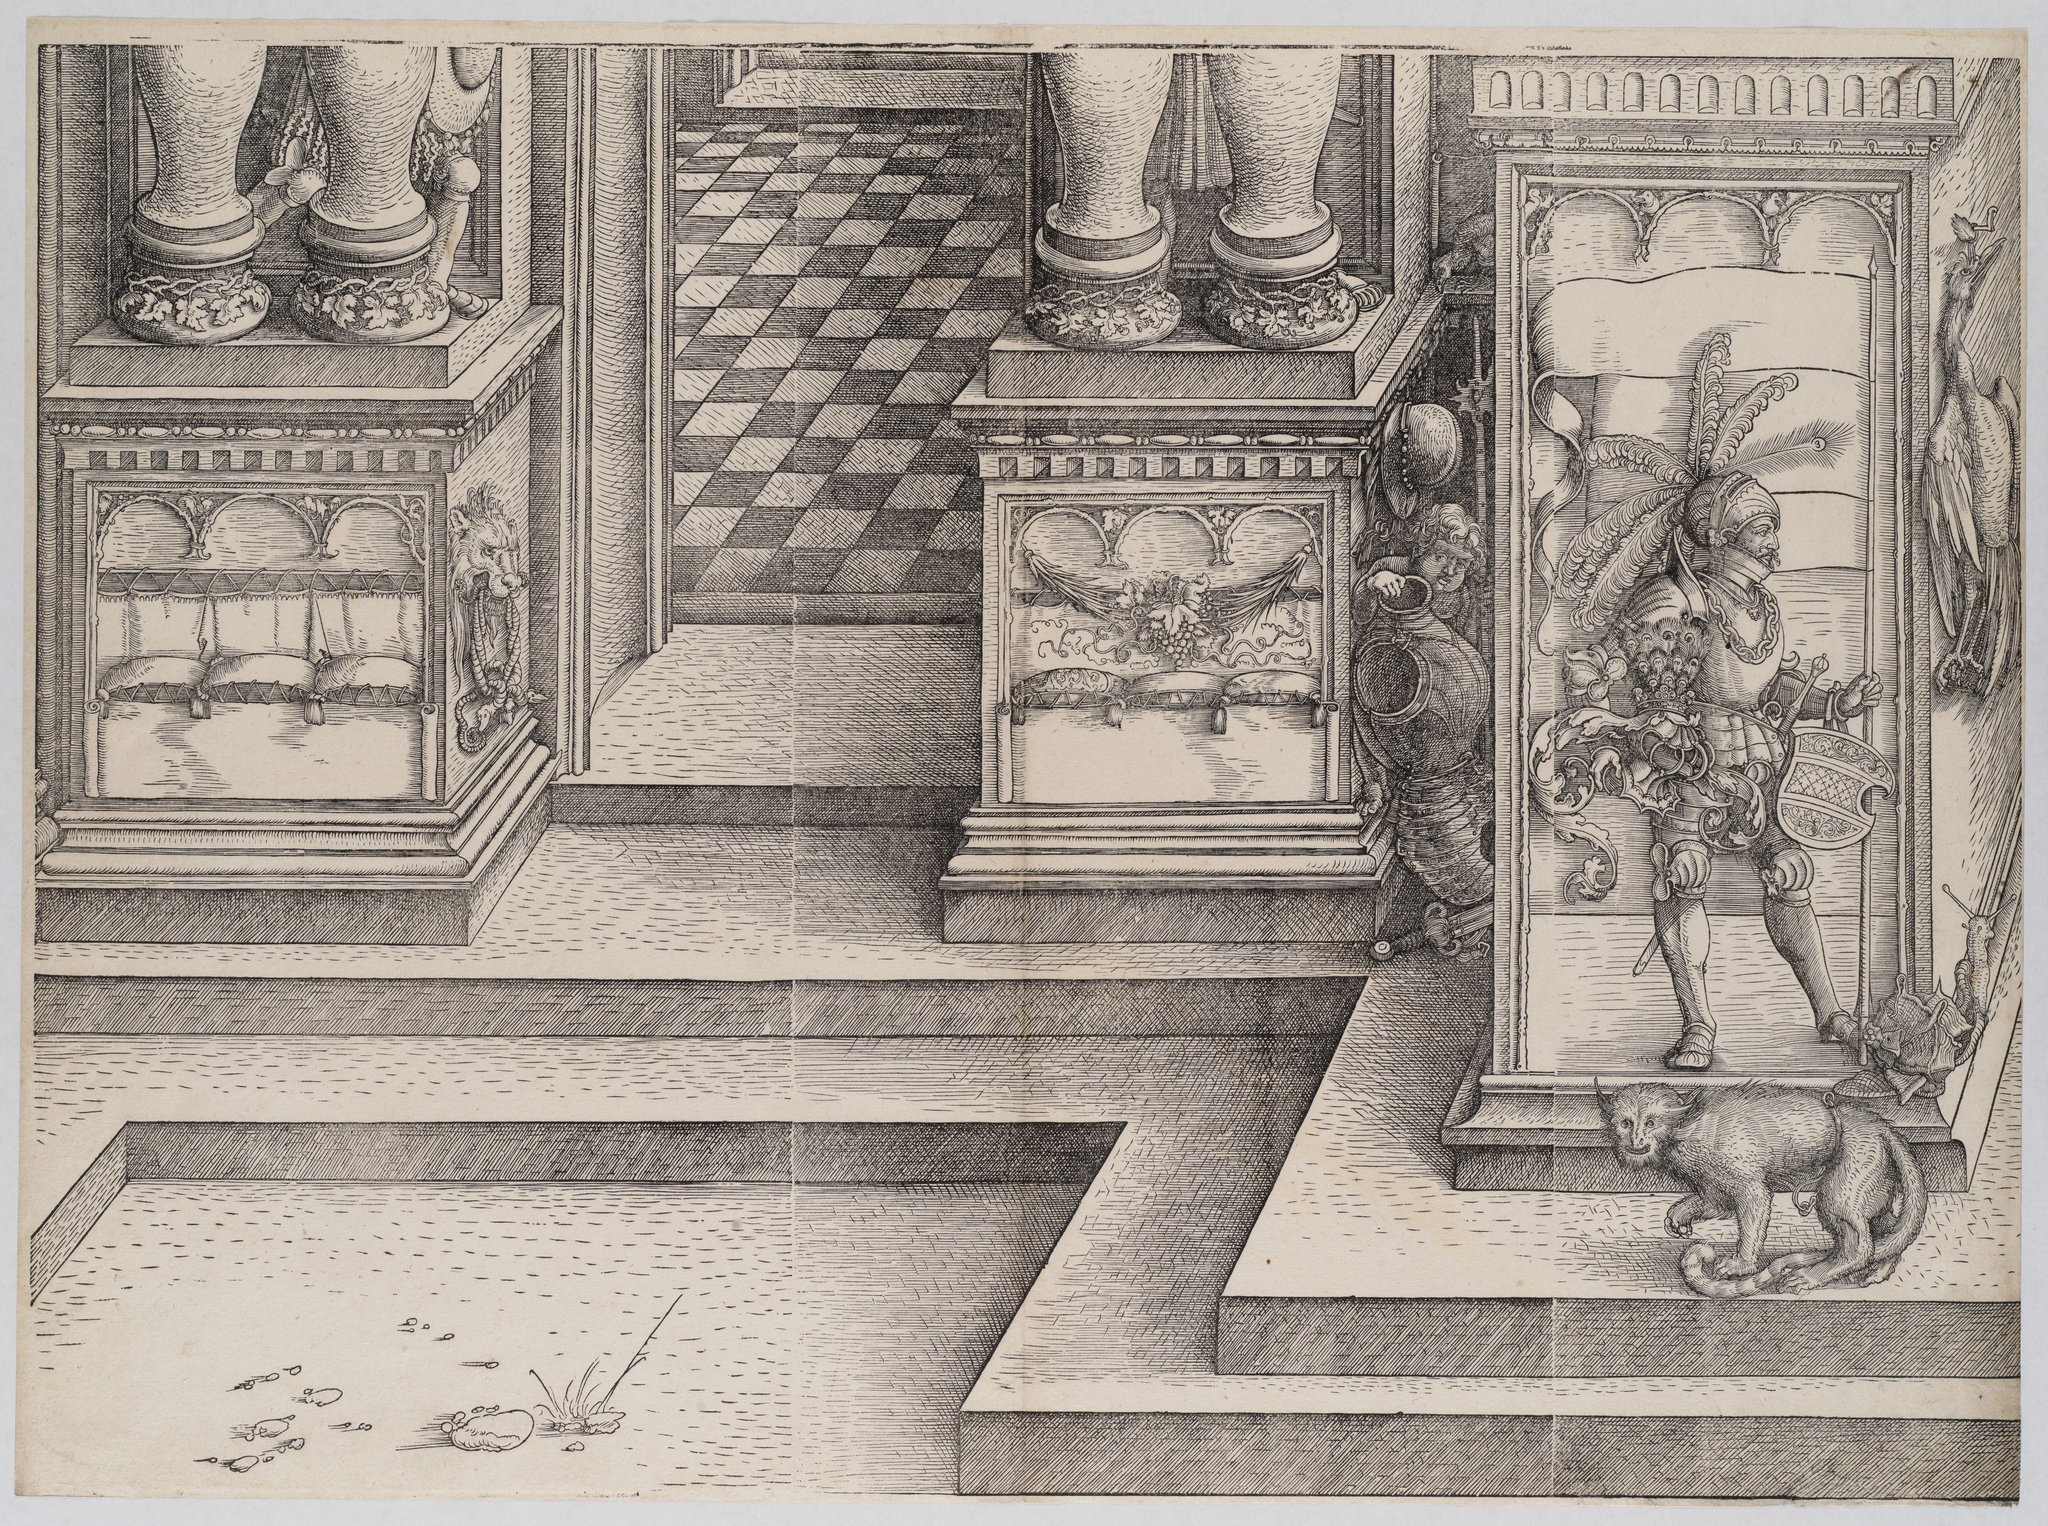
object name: print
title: The Lower Portion of the Entryway to the Left Portal (Die Porten des Lobs); and the Outer Left Sockel of the Central Portal, from the Arch of Honor, proof, dated 1515, printed 1517-18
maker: hans springinklee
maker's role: artist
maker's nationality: german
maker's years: 1495-1530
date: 1515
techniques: woodcut